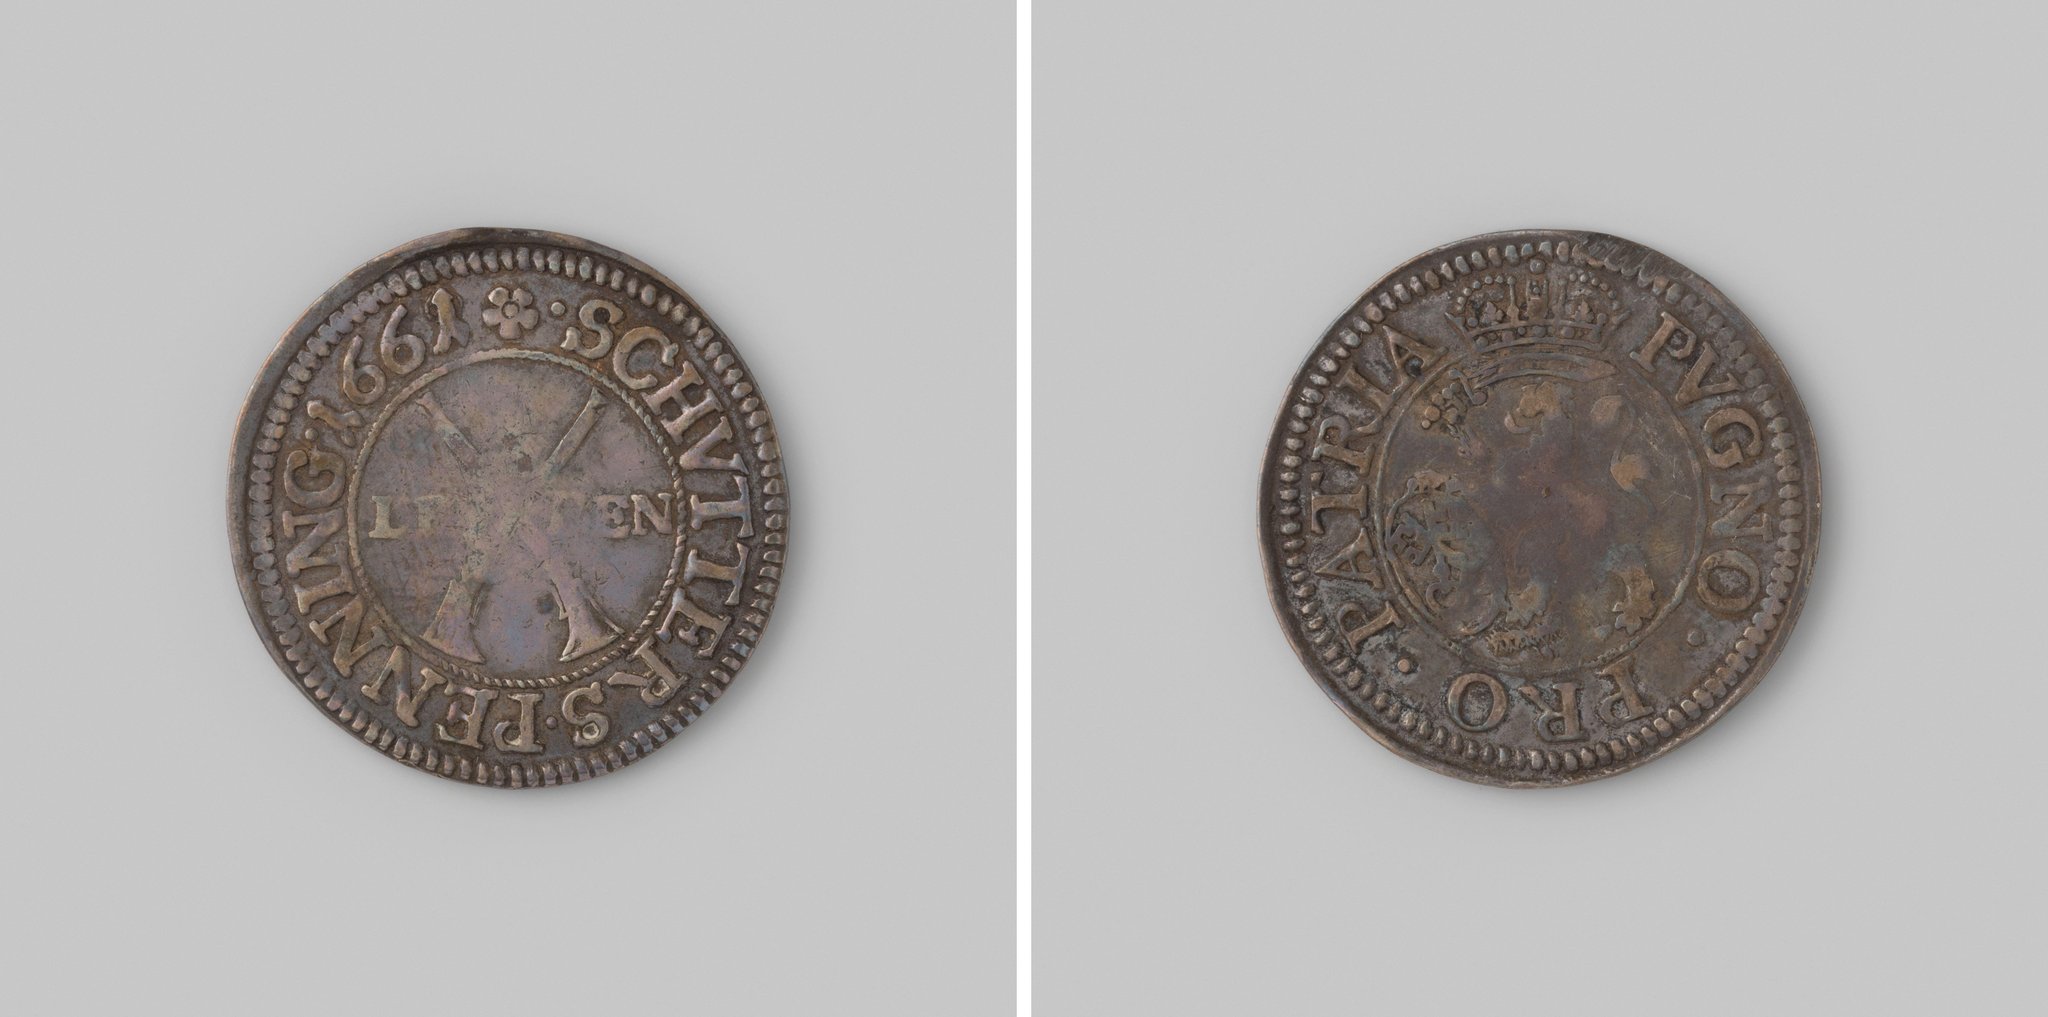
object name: marksman medal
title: Schutterspenning van Leiden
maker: Anonymous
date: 1661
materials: silver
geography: leiden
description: Zilveren schutterspenning van Leiden. Voorzijde: een gekroonde klimmende leeuw met een zwaard in zijn rechter en een schild met het Leidse wapen in zijn linker klauw. Omschrift: PVGNO PRO PATRIA (ik vecht voor het vaderland). Keerzijde: twee gekruiste musketten tussen LEY en DEN. Omschrift: SCHVTTERS PENNING en daarachter het jaartal.